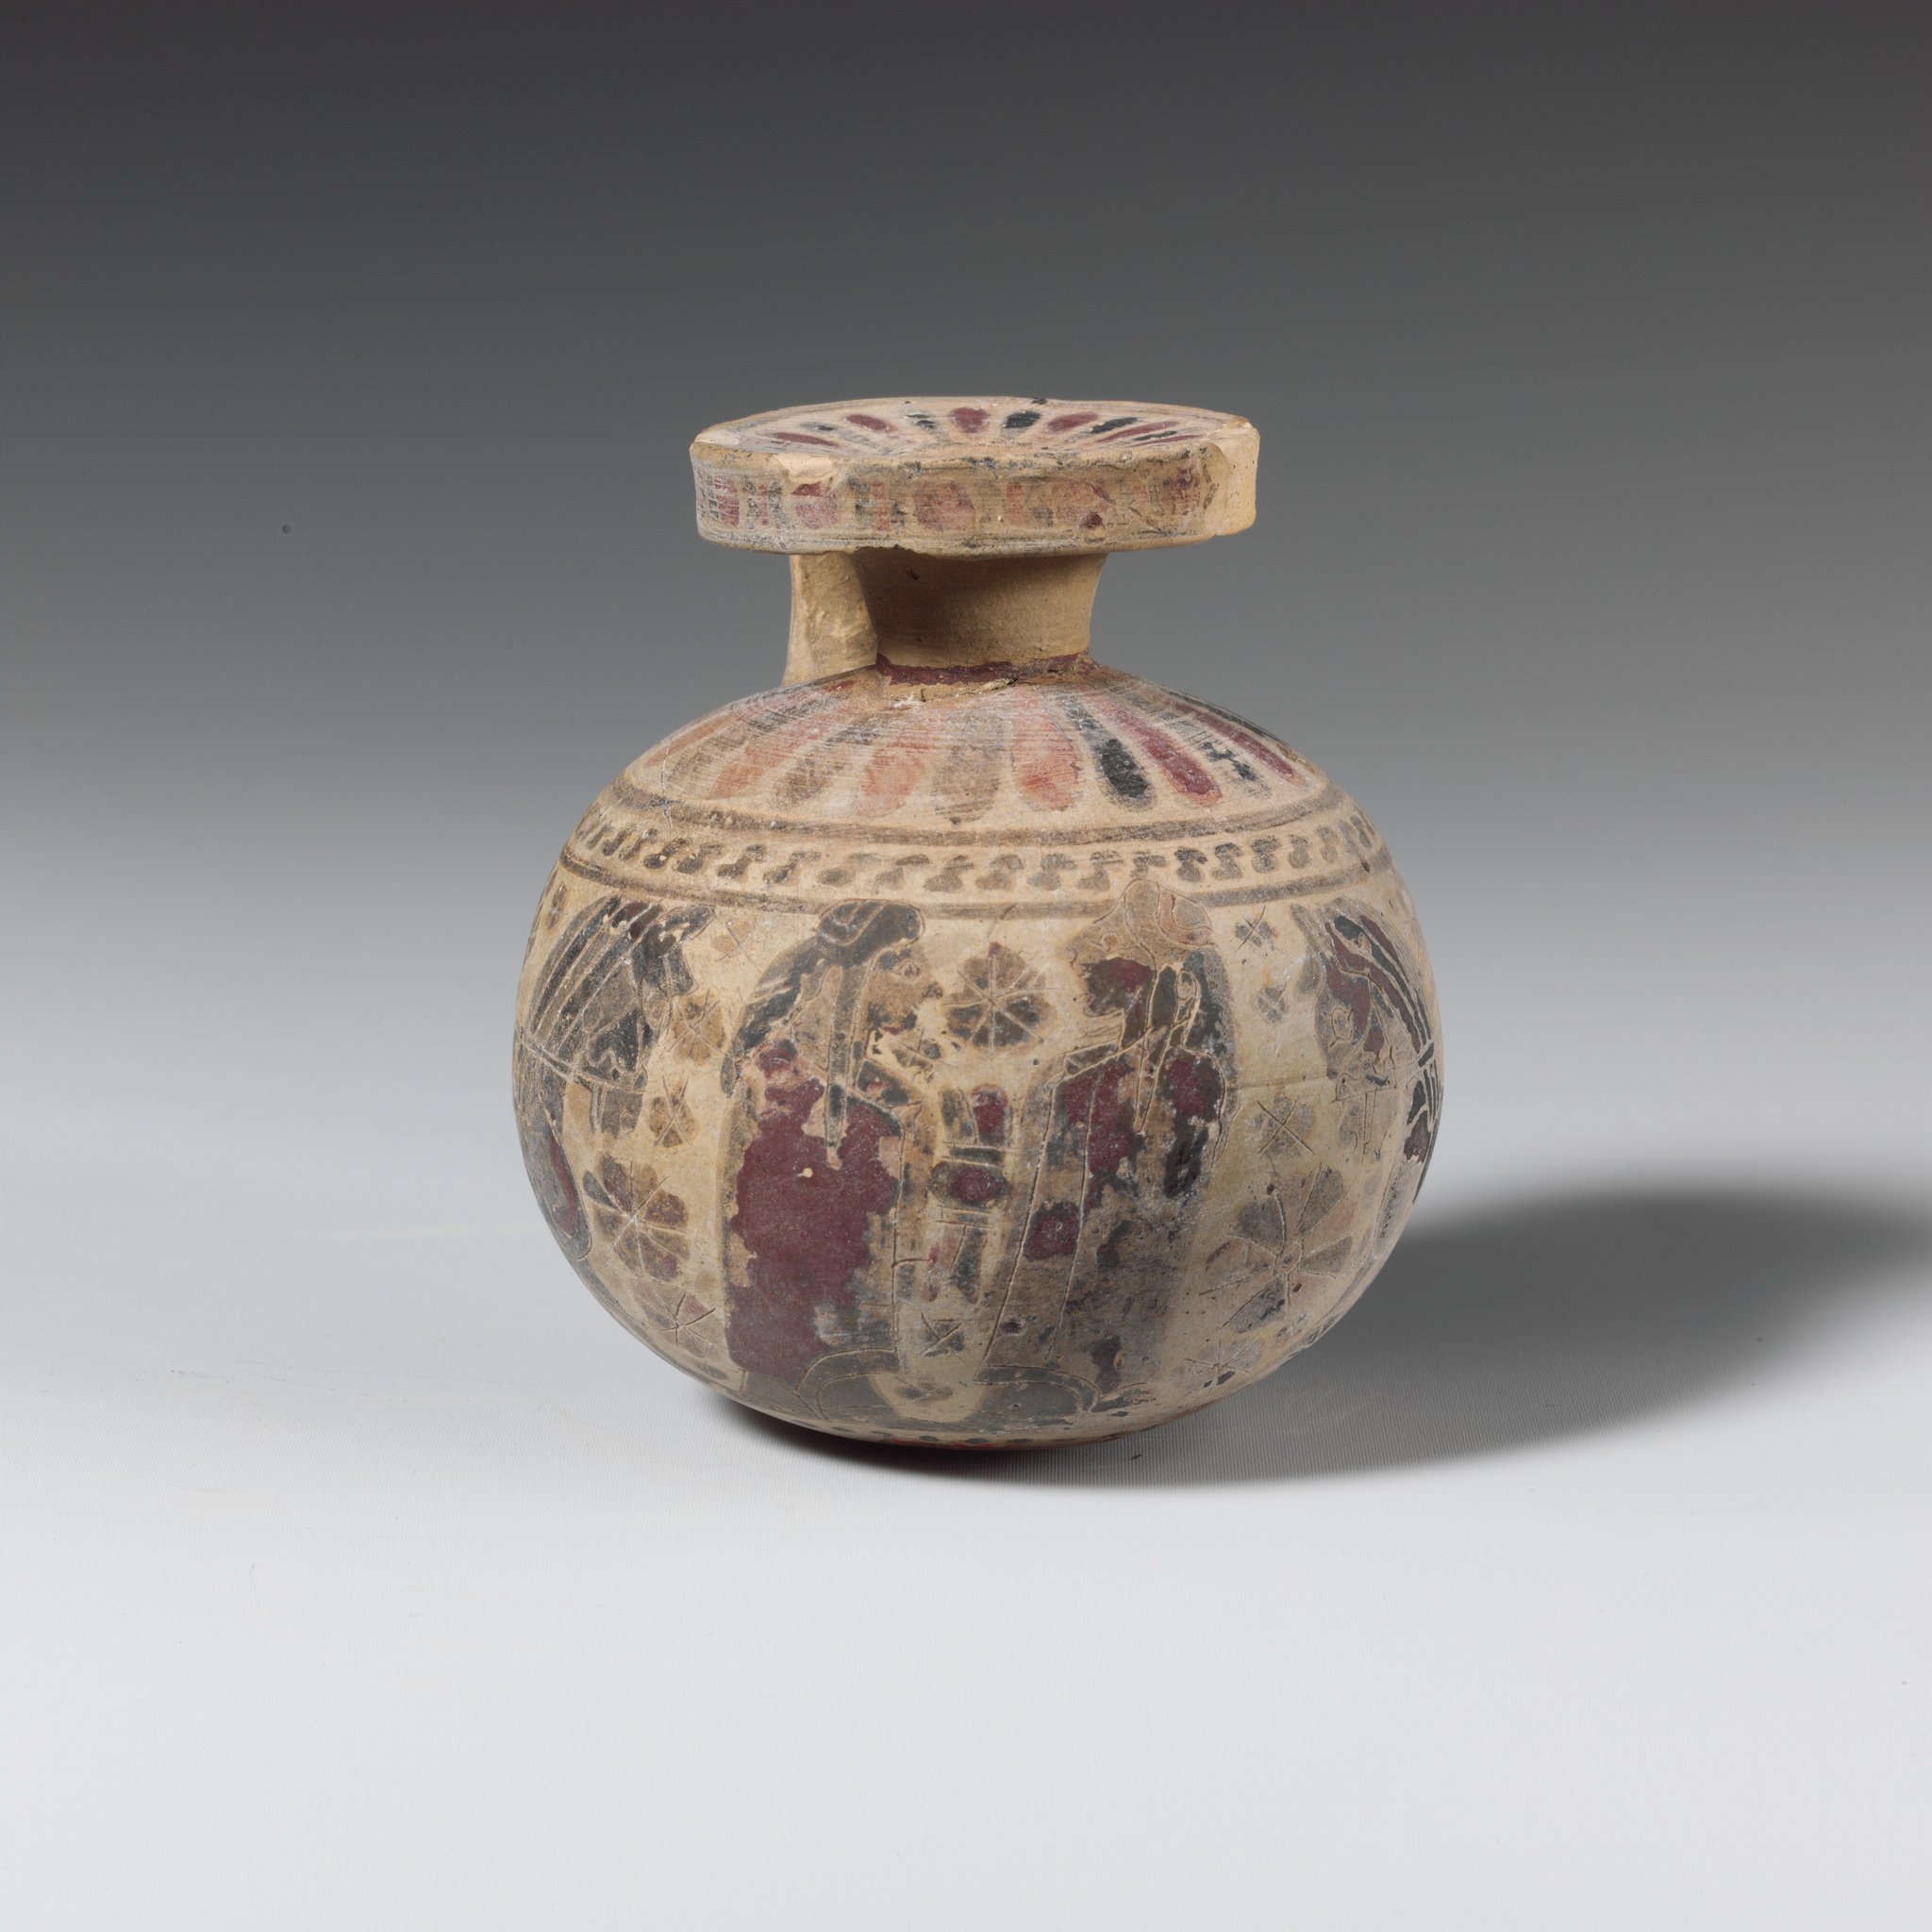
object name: aryballos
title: Terracotta aryballos (oil flask)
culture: greek, corinthian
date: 620-590 BCE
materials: terracotta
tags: men,horses